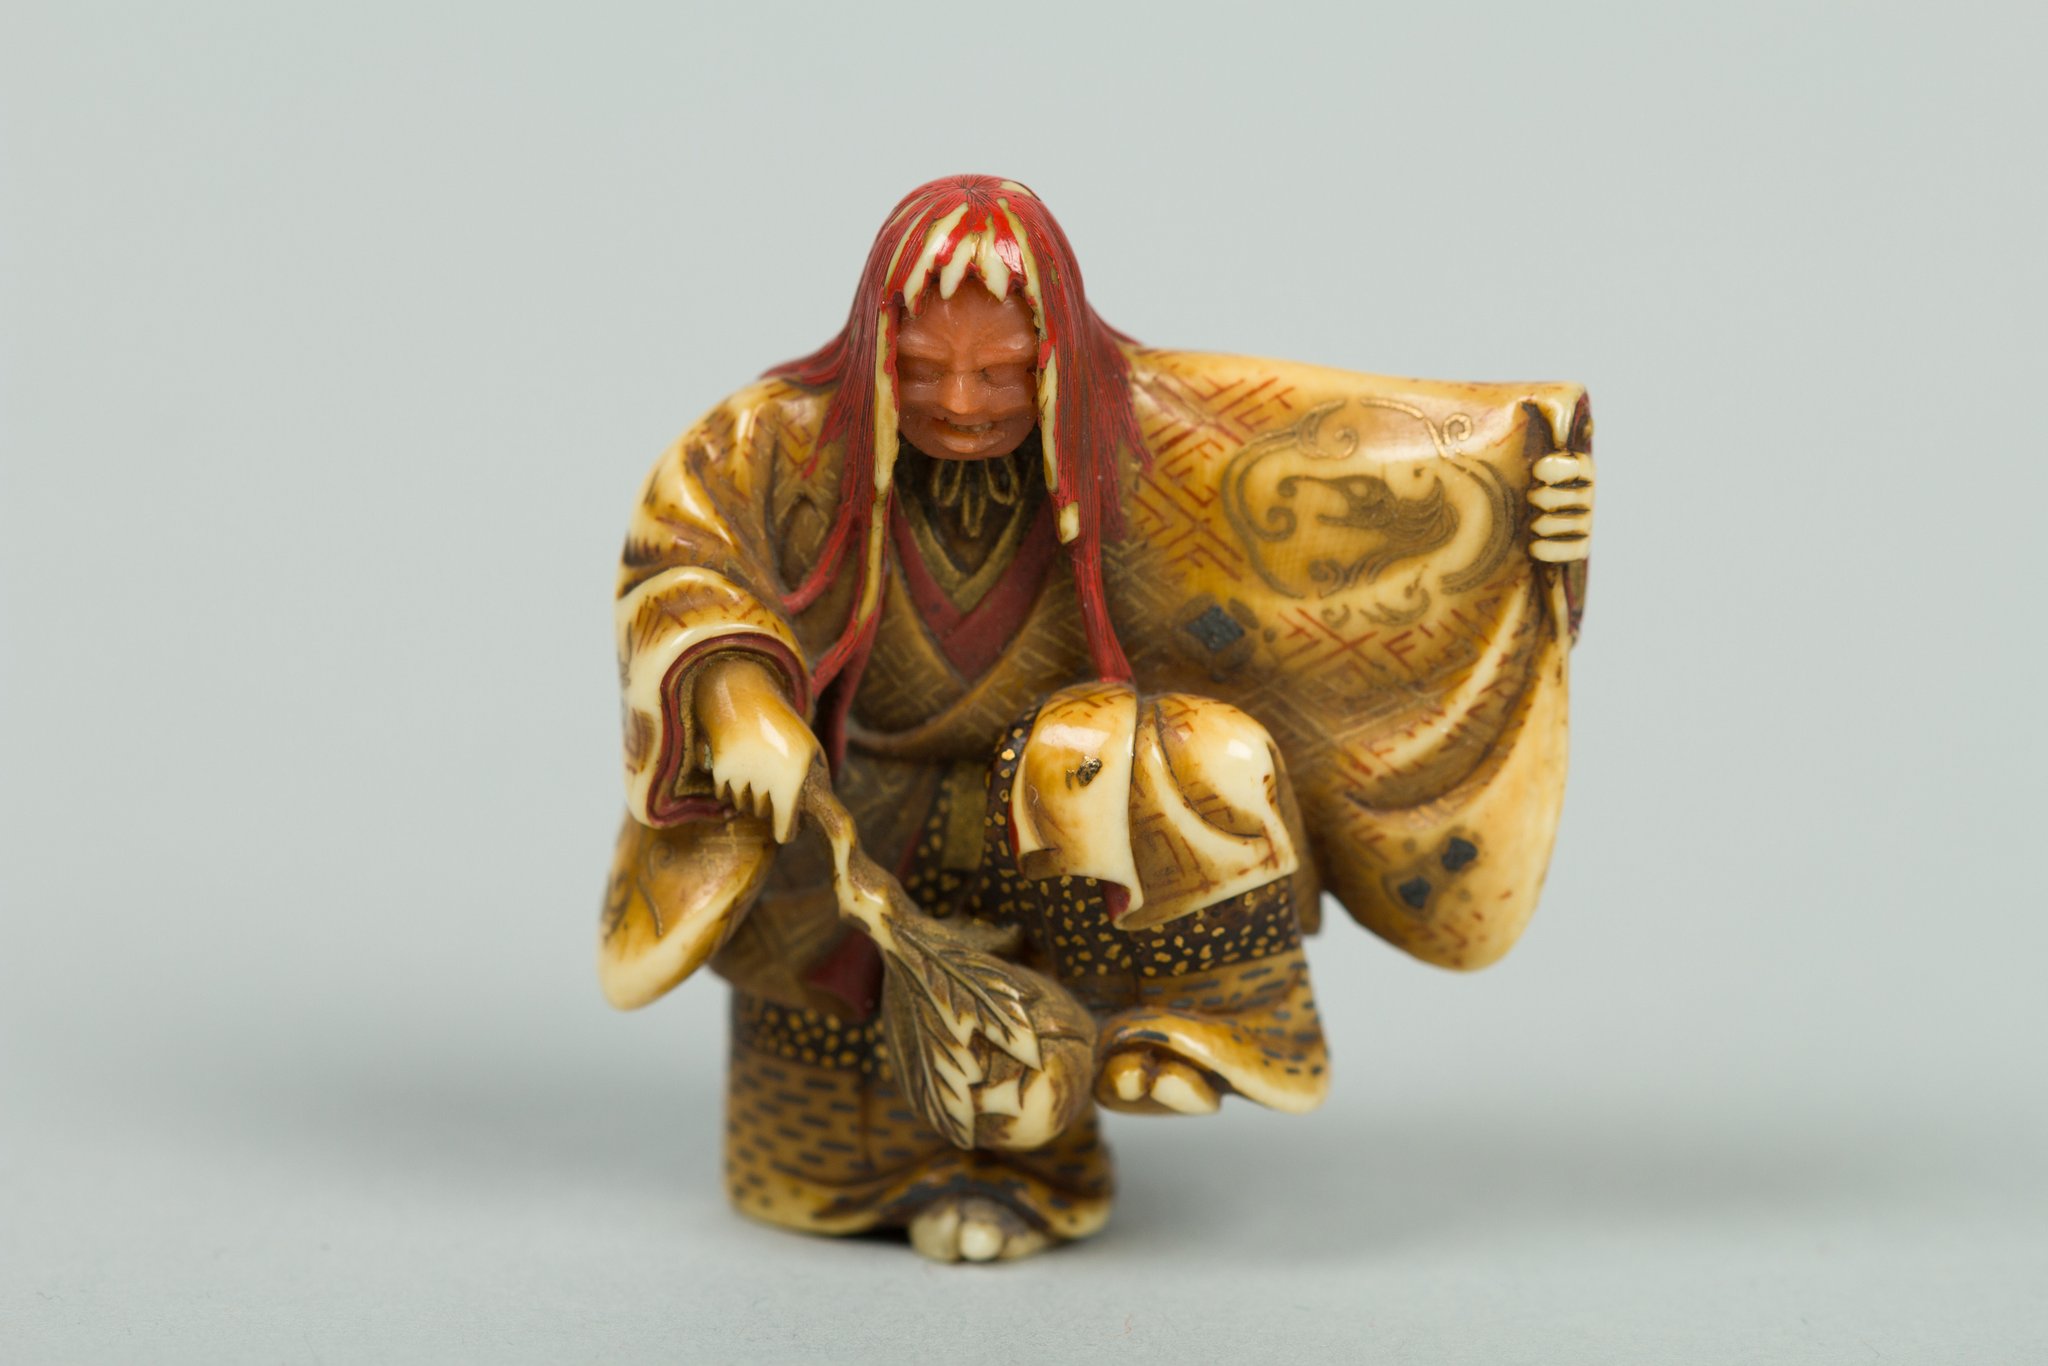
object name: netsuke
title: Netsuke of Noh Dancer with Long Red Hair and Peony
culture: japanese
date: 1801-1900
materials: gold, ivory, lacquer, stone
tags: human figures,dancers